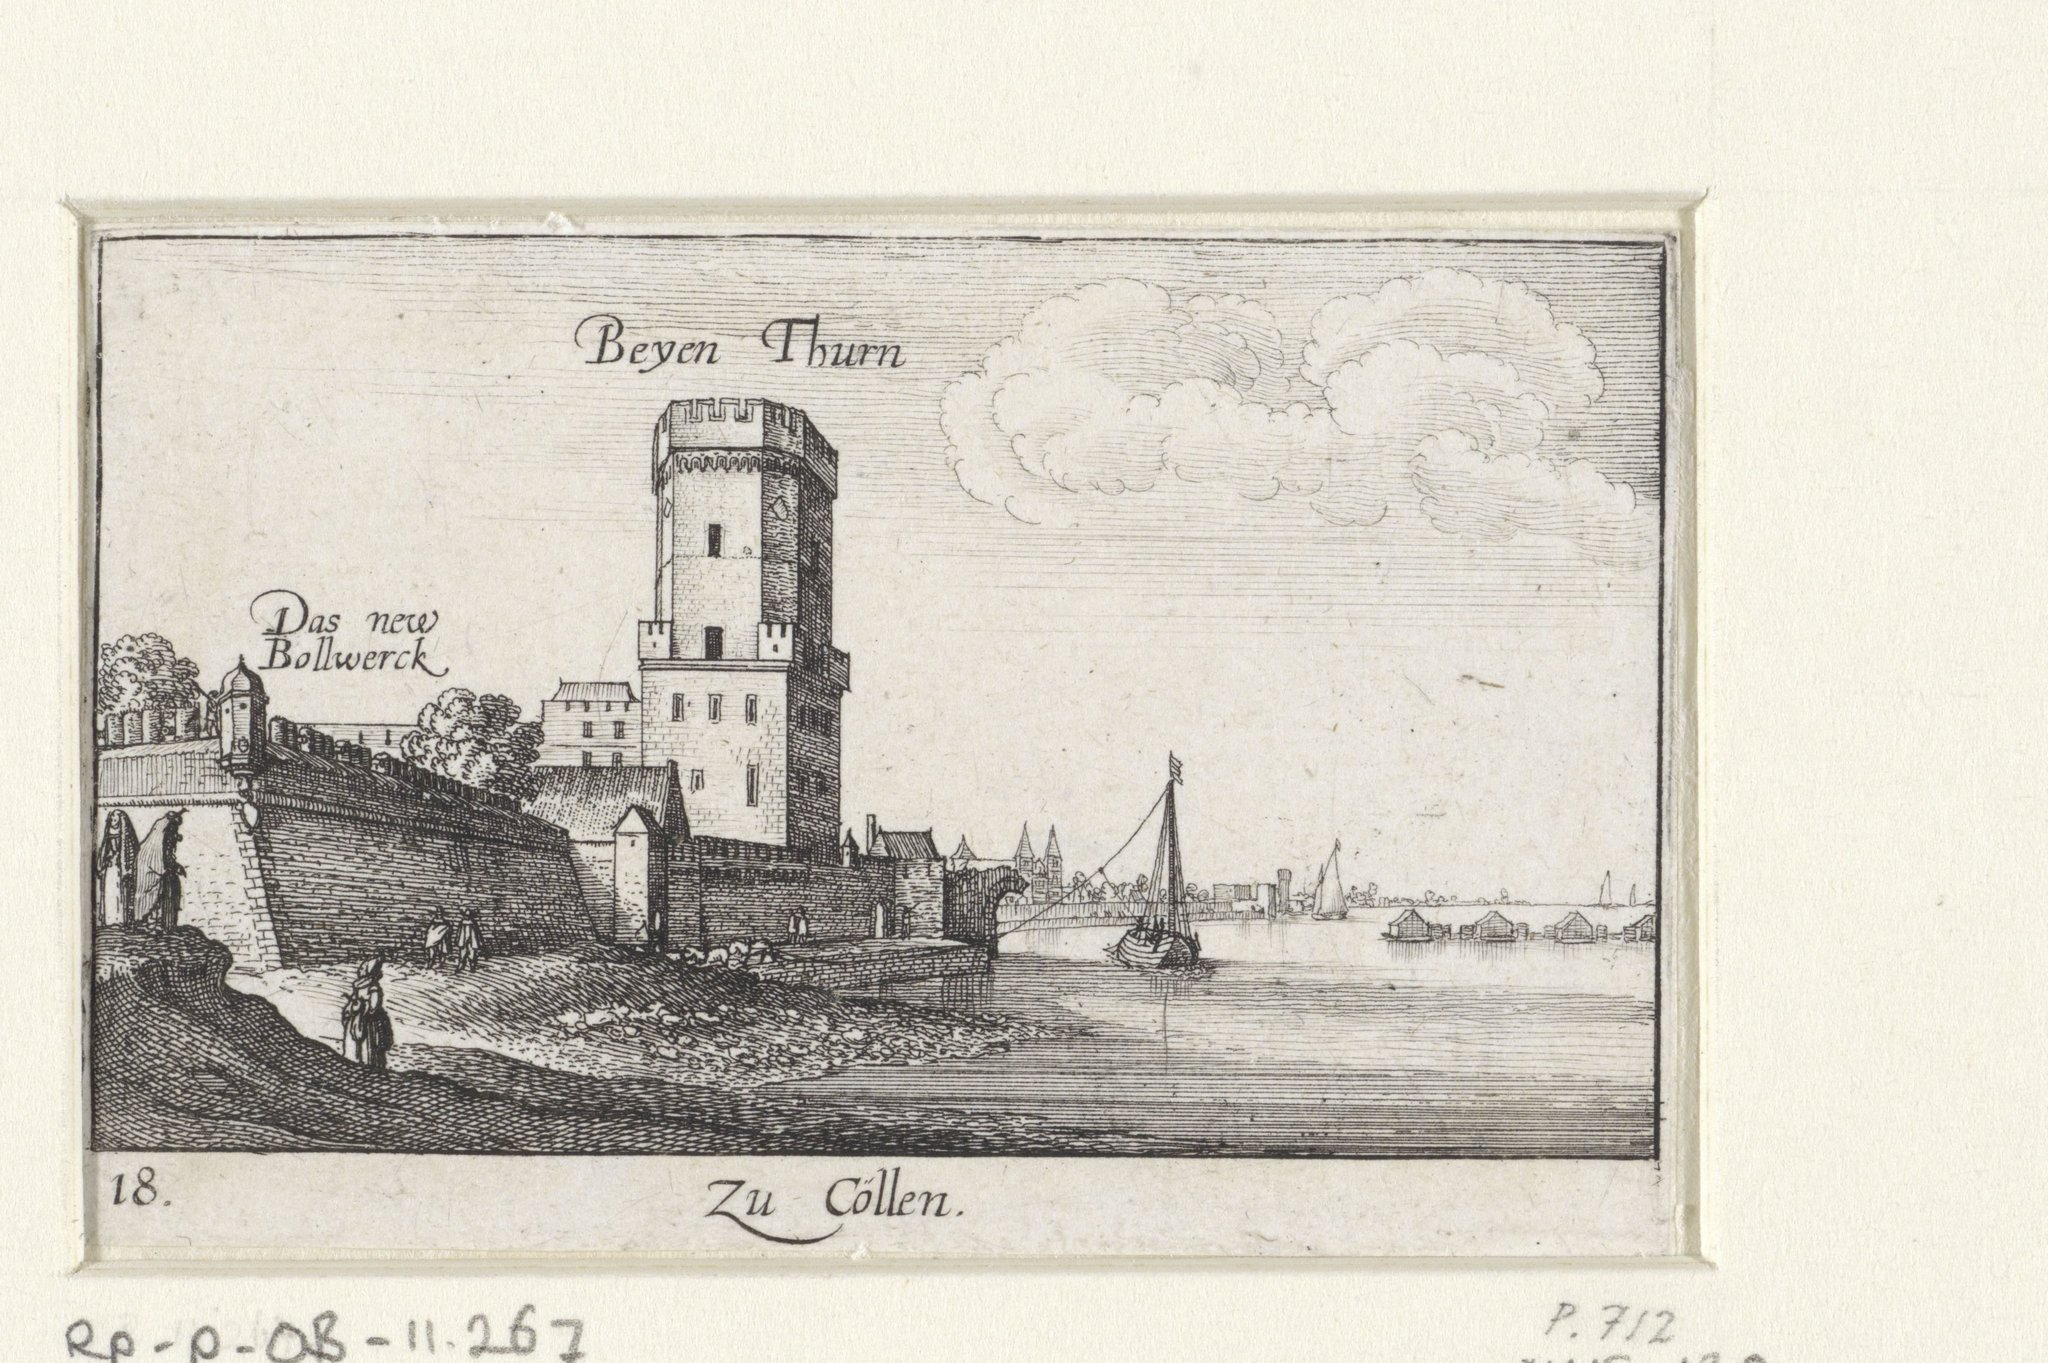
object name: print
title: Gezicht op stadsmuren van Keulen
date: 1635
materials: paper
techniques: etching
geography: cologne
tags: city-view, and landscape with man-made constructions, city-walls, cologne